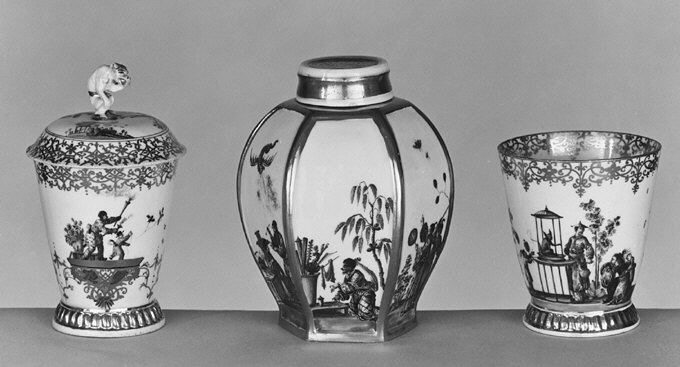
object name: tea caddy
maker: meissen manufactory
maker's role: manufactory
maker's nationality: german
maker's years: 1710-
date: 1725-1730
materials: hard paste porcelain